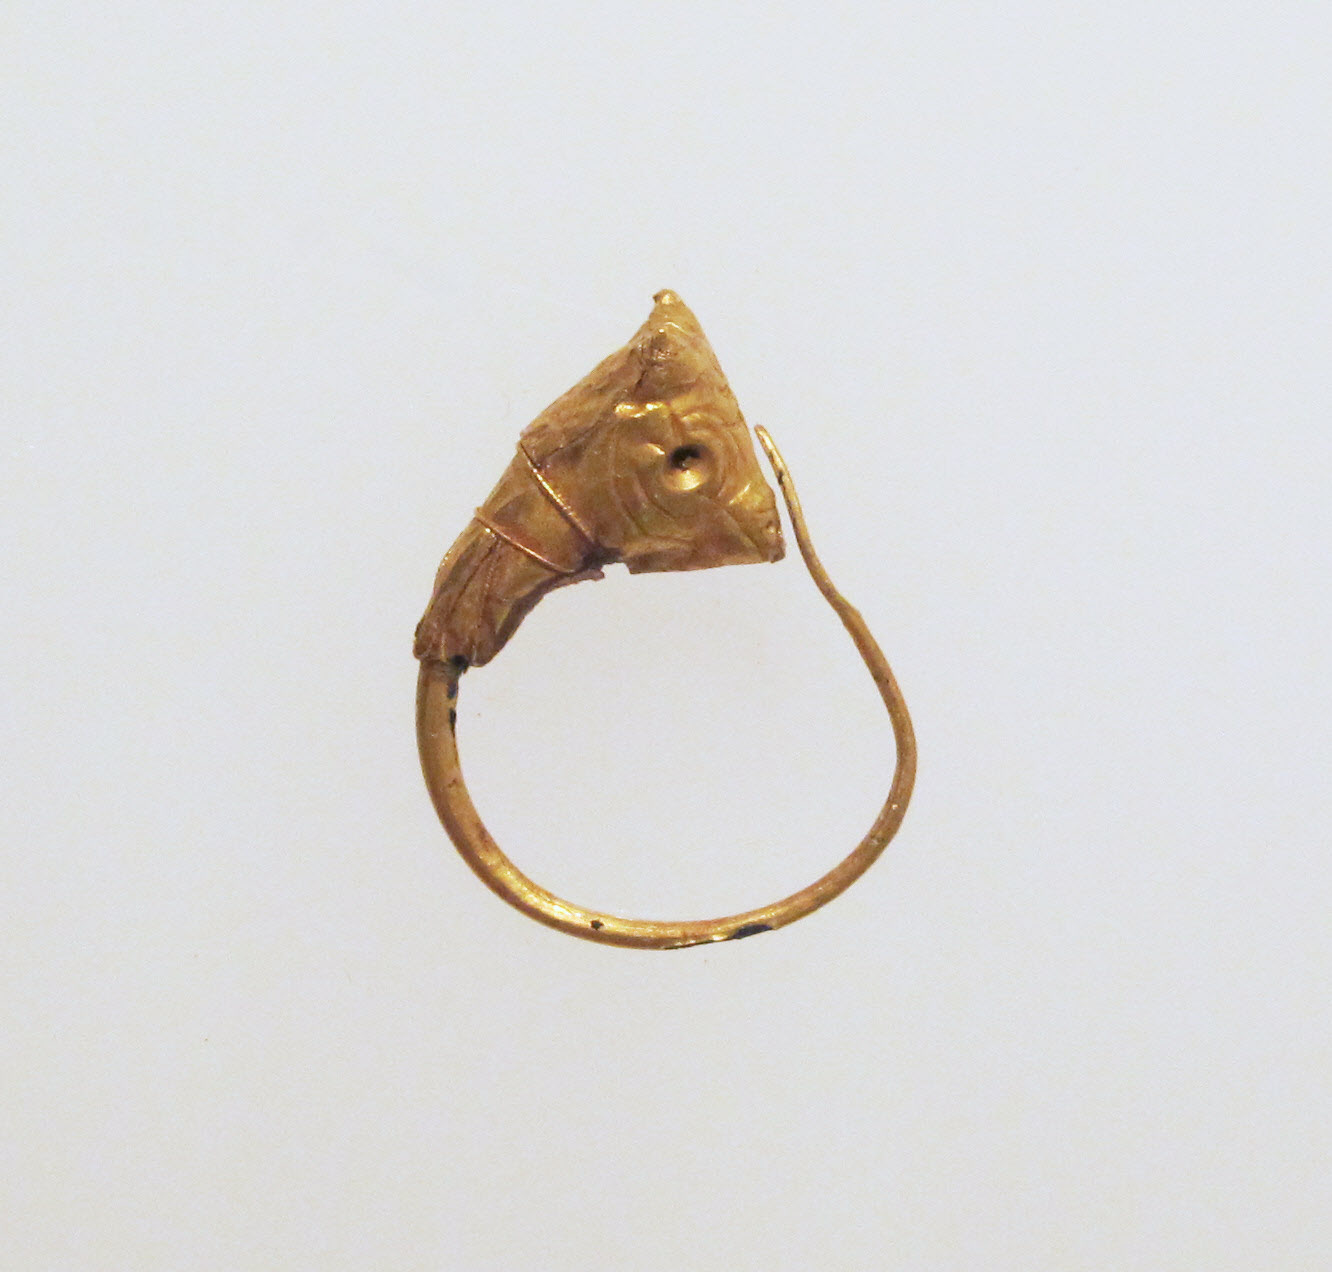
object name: earring with head of bull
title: Gold earring with head of a bull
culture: greek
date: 400-201 BCE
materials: gold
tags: bulls